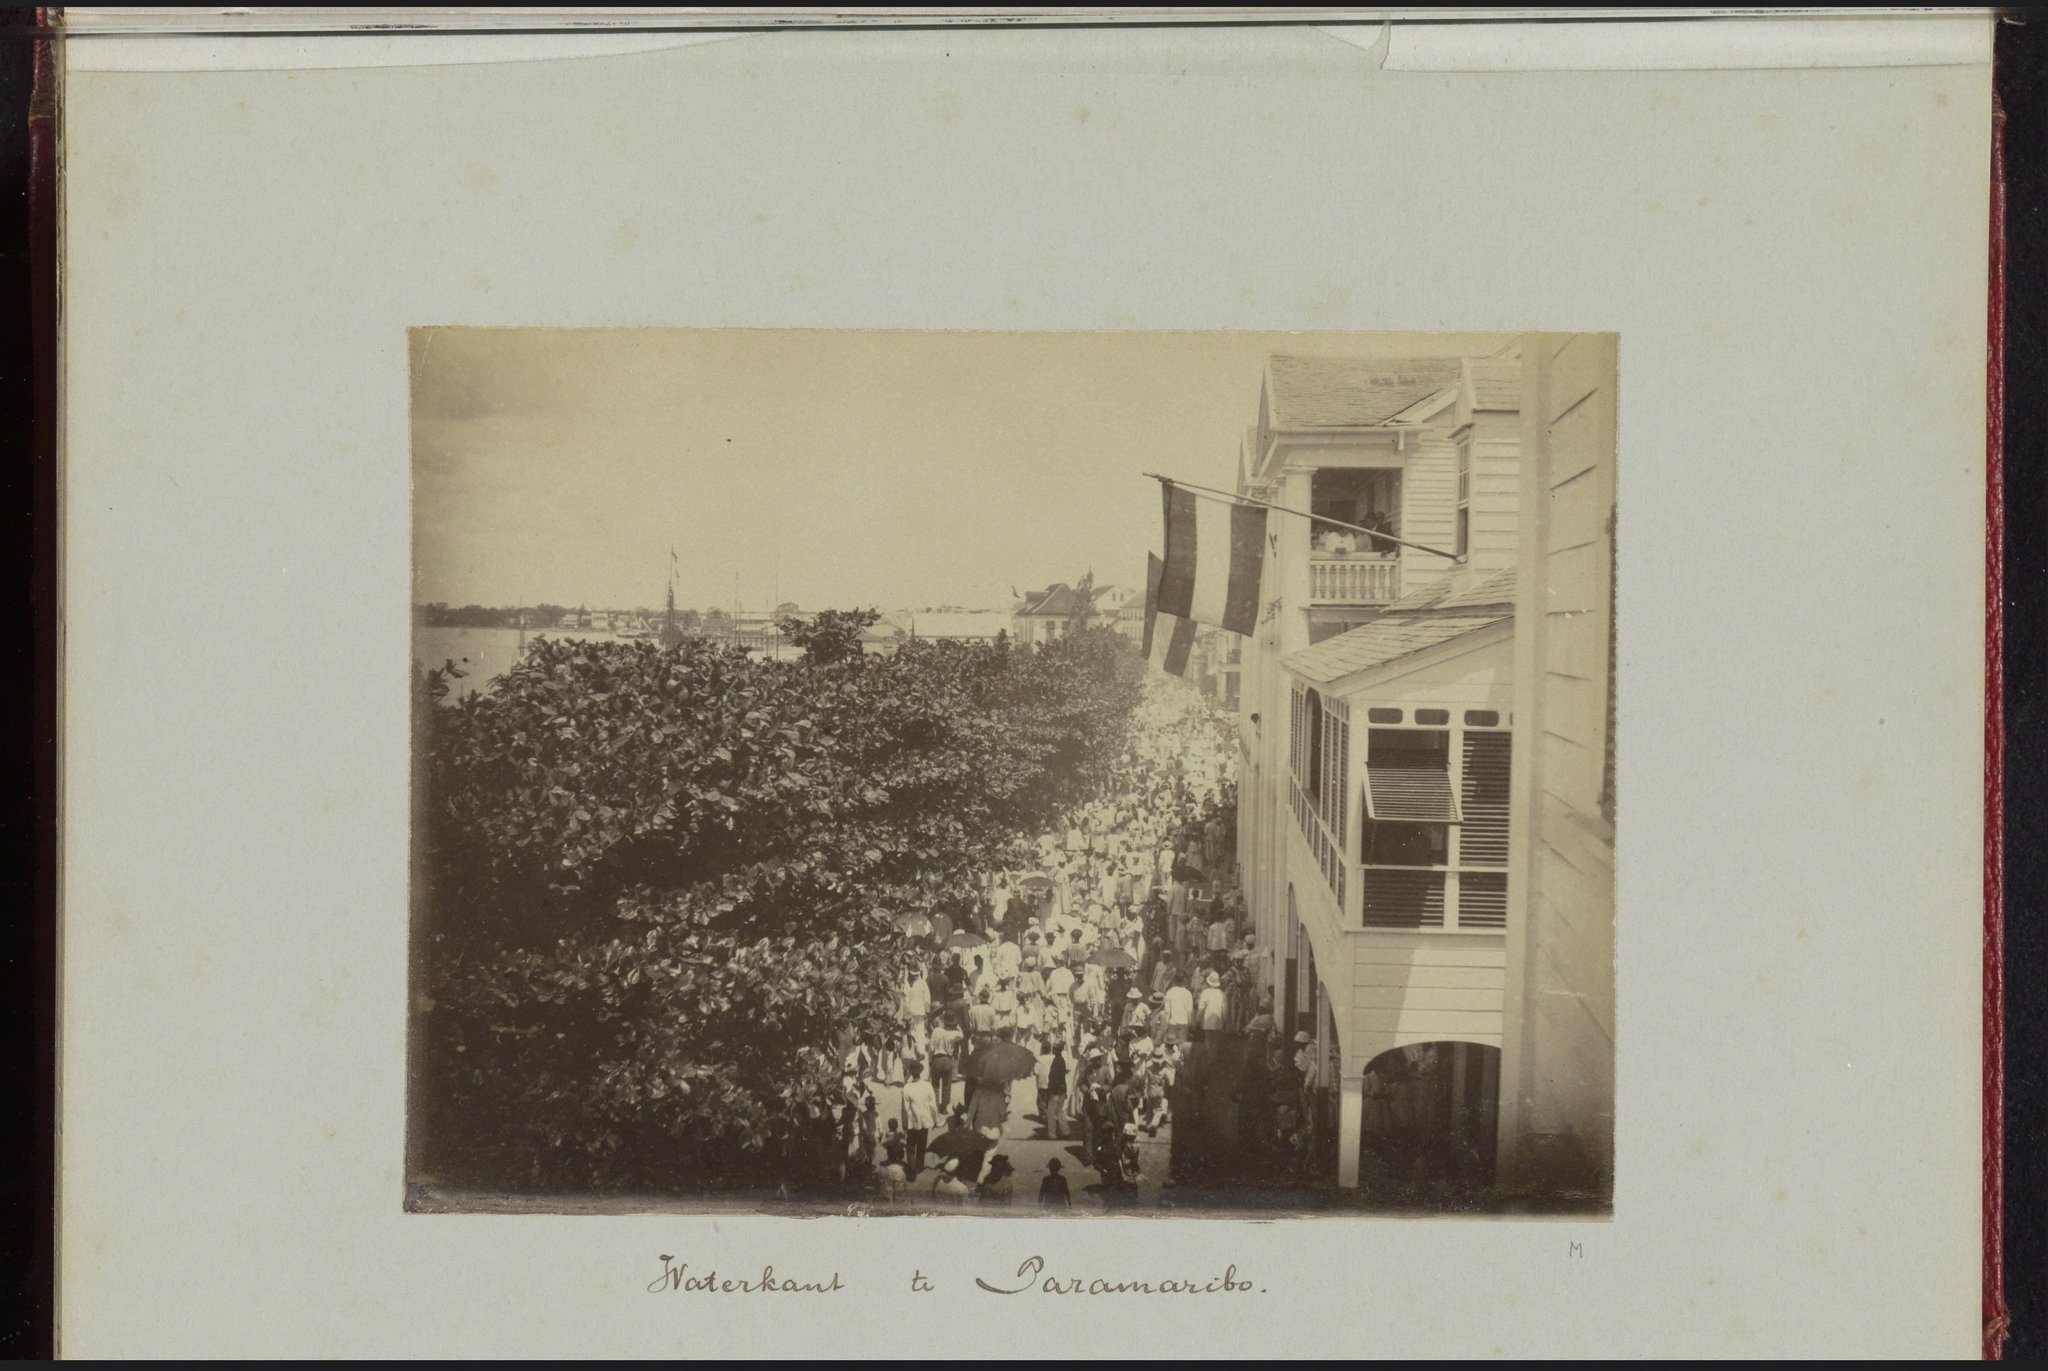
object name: photograph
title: Gezicht op een menigte aan de Waterkant in Paramaribo met Koninginnedag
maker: Anonymous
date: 1880-1900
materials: photographic support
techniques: albumen print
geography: waterkant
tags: public festivities on the occasion of royal events, flags flown from a mast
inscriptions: inscription: ‘Rives No. 7 NPA’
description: Onderdeel van Fotoalbum met opnames van bezienswaardigheden in Europa, Trinidad, Haïti, Martinique en Suriname.